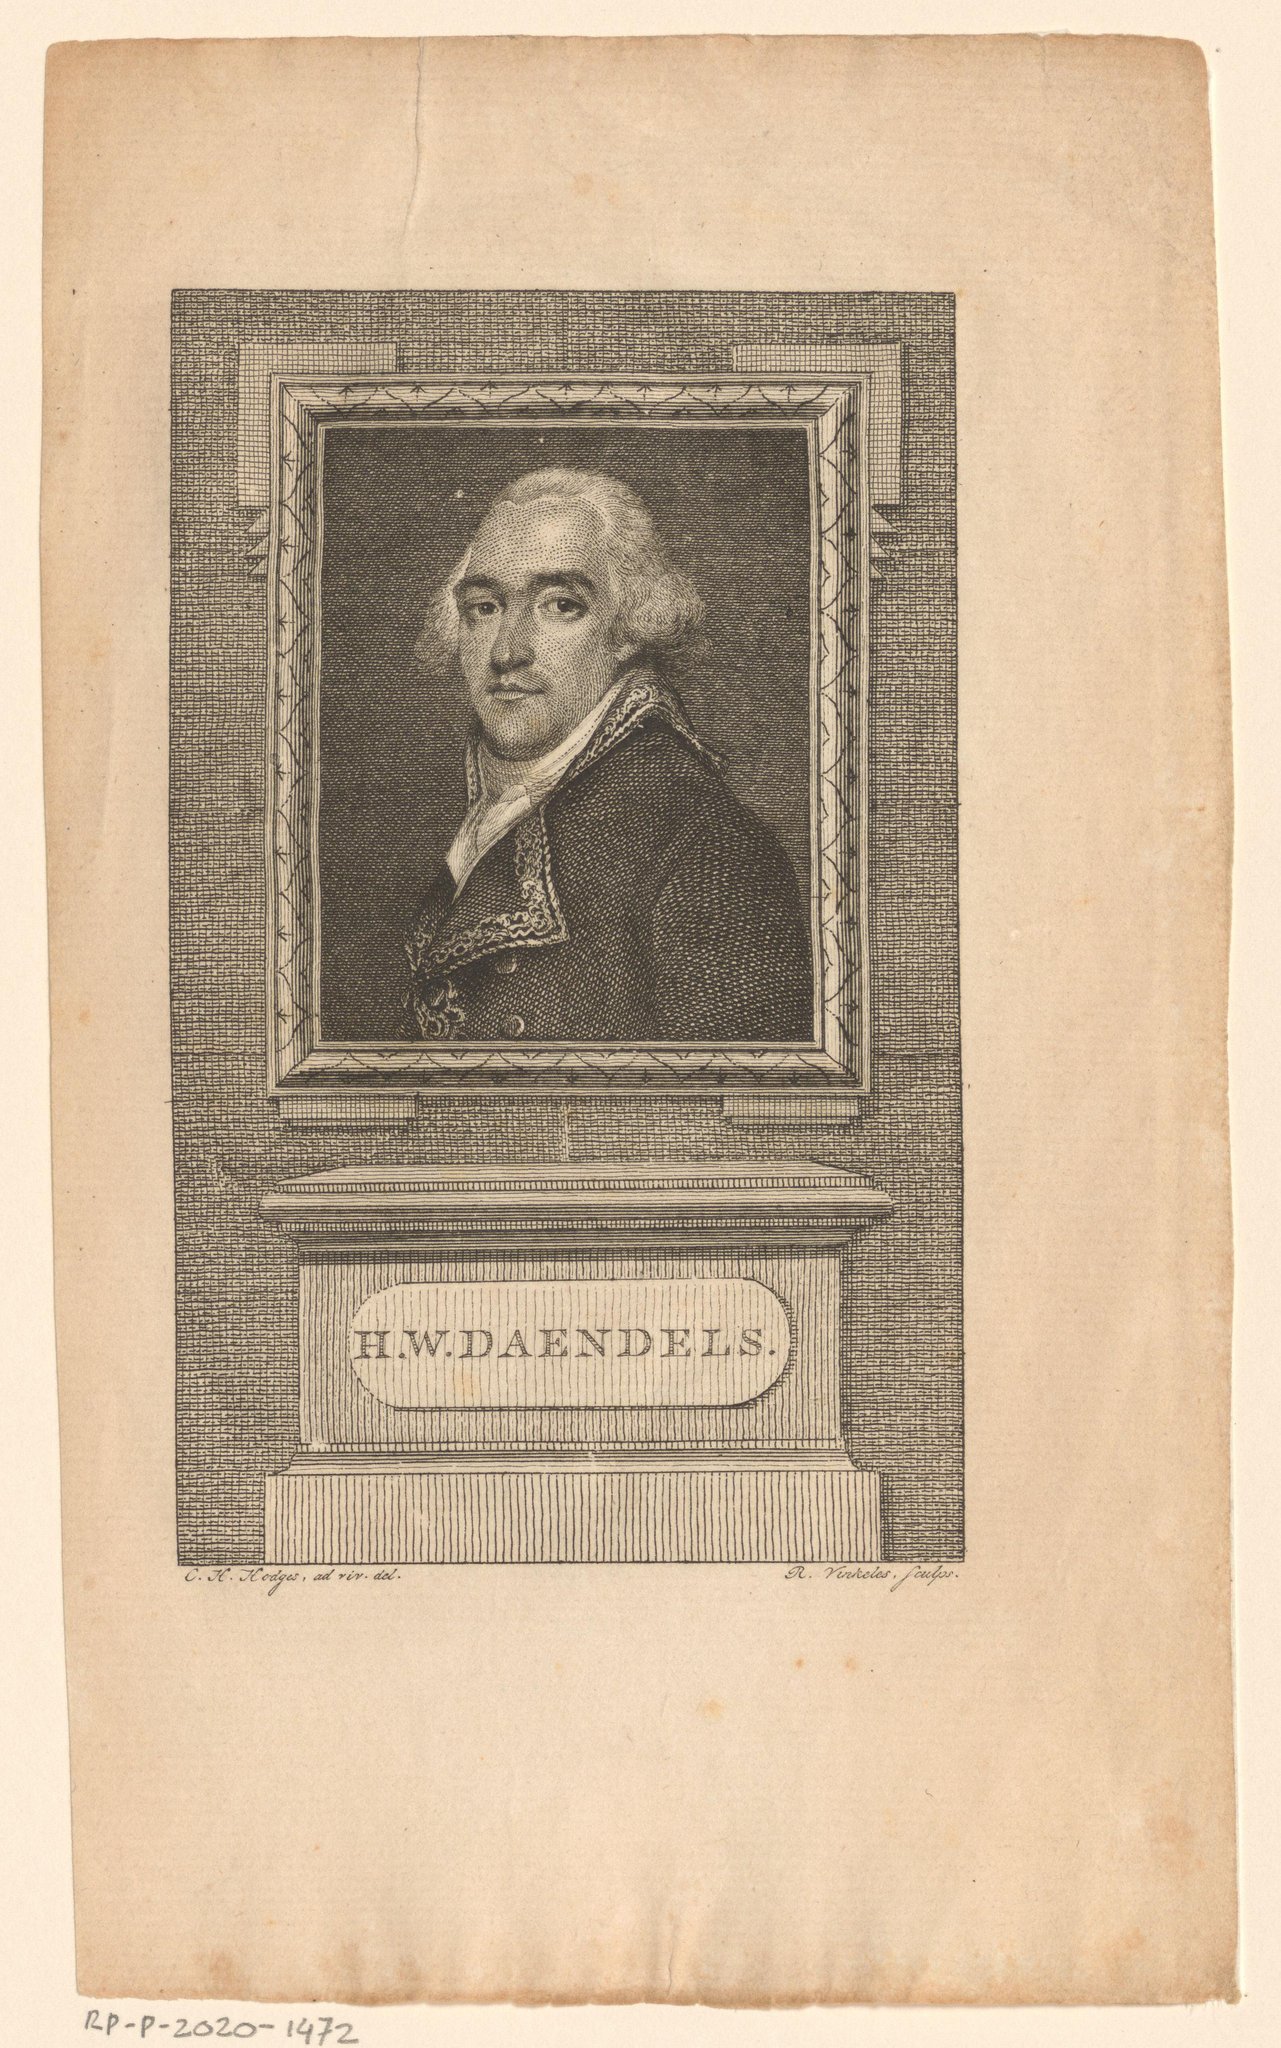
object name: print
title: Portret van Herman Willem Daendels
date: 1802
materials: paper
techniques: engraving, etching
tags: herman willem daendels, commander-in-chief, general, marshal, historical persons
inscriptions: collector's mark: Lugt 2228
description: Huidige staat van prent gebruikt in: Wagenaar, Jan. Vaderlandsche historie, vervattende de geschiedenissen der vereenigde Nederlanden (...). 43 dln. Amsterdam: Johannes Allart, 1802, dl. 29.